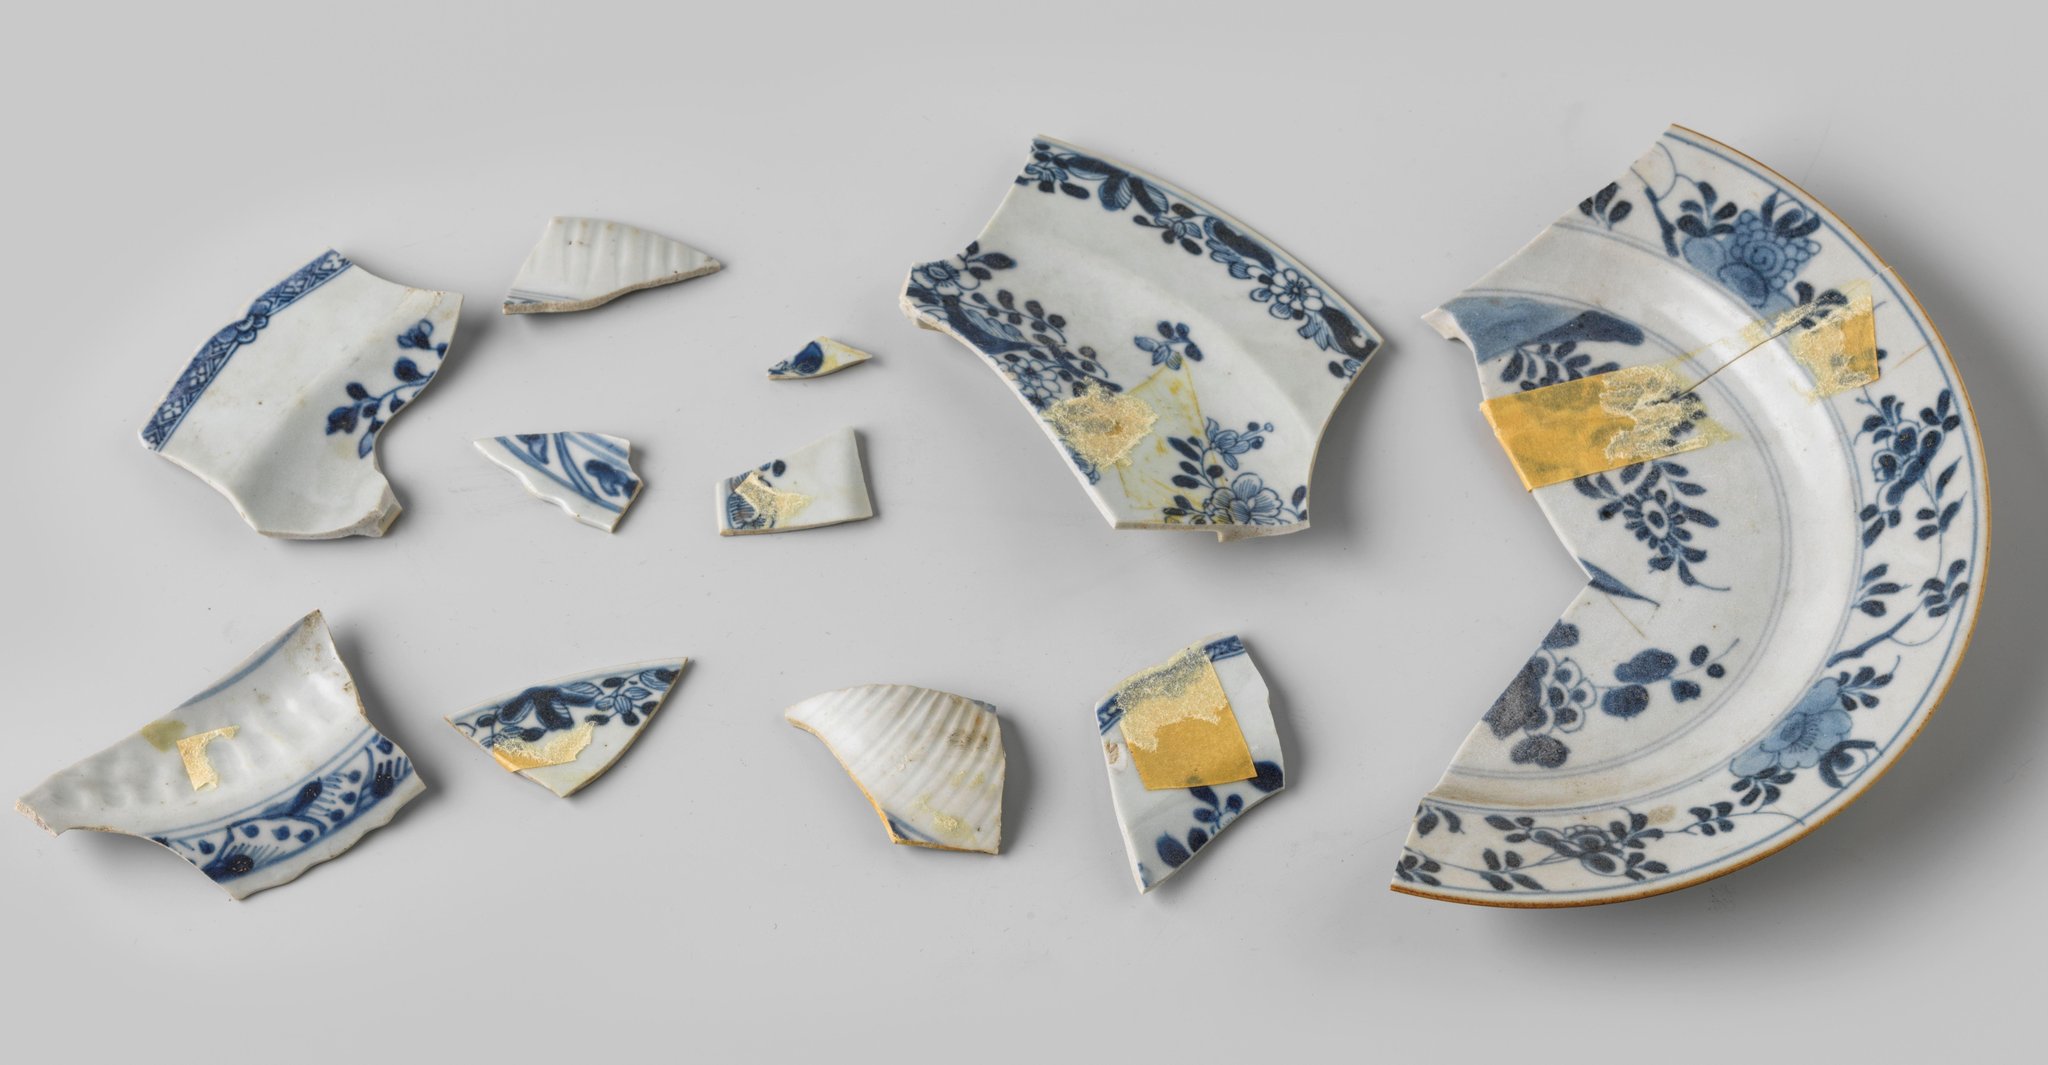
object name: bowl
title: Kom, gevonden bij V.O.C.-schip Witte Leeuw, mogelijk afkomstig van Zeelelie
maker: Anonymous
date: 1725-1800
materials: porcelain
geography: jingdezhen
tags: verenigde oostindische compagnie, sint-helena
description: A bowl. A large bowl, deeply vaulted, on a high footring with a flaring lip-rim. The base is glazed, the rim of the footring unglazed. The body is grey-white. There is a clear blue accurate painting under a bluish white translucent glaze. A central decoration of a garden with peonies and other flowers, a willow, a rock and a fence. On the lip-rim are 4 medallions with flowers and a frieze with trellis pattern.